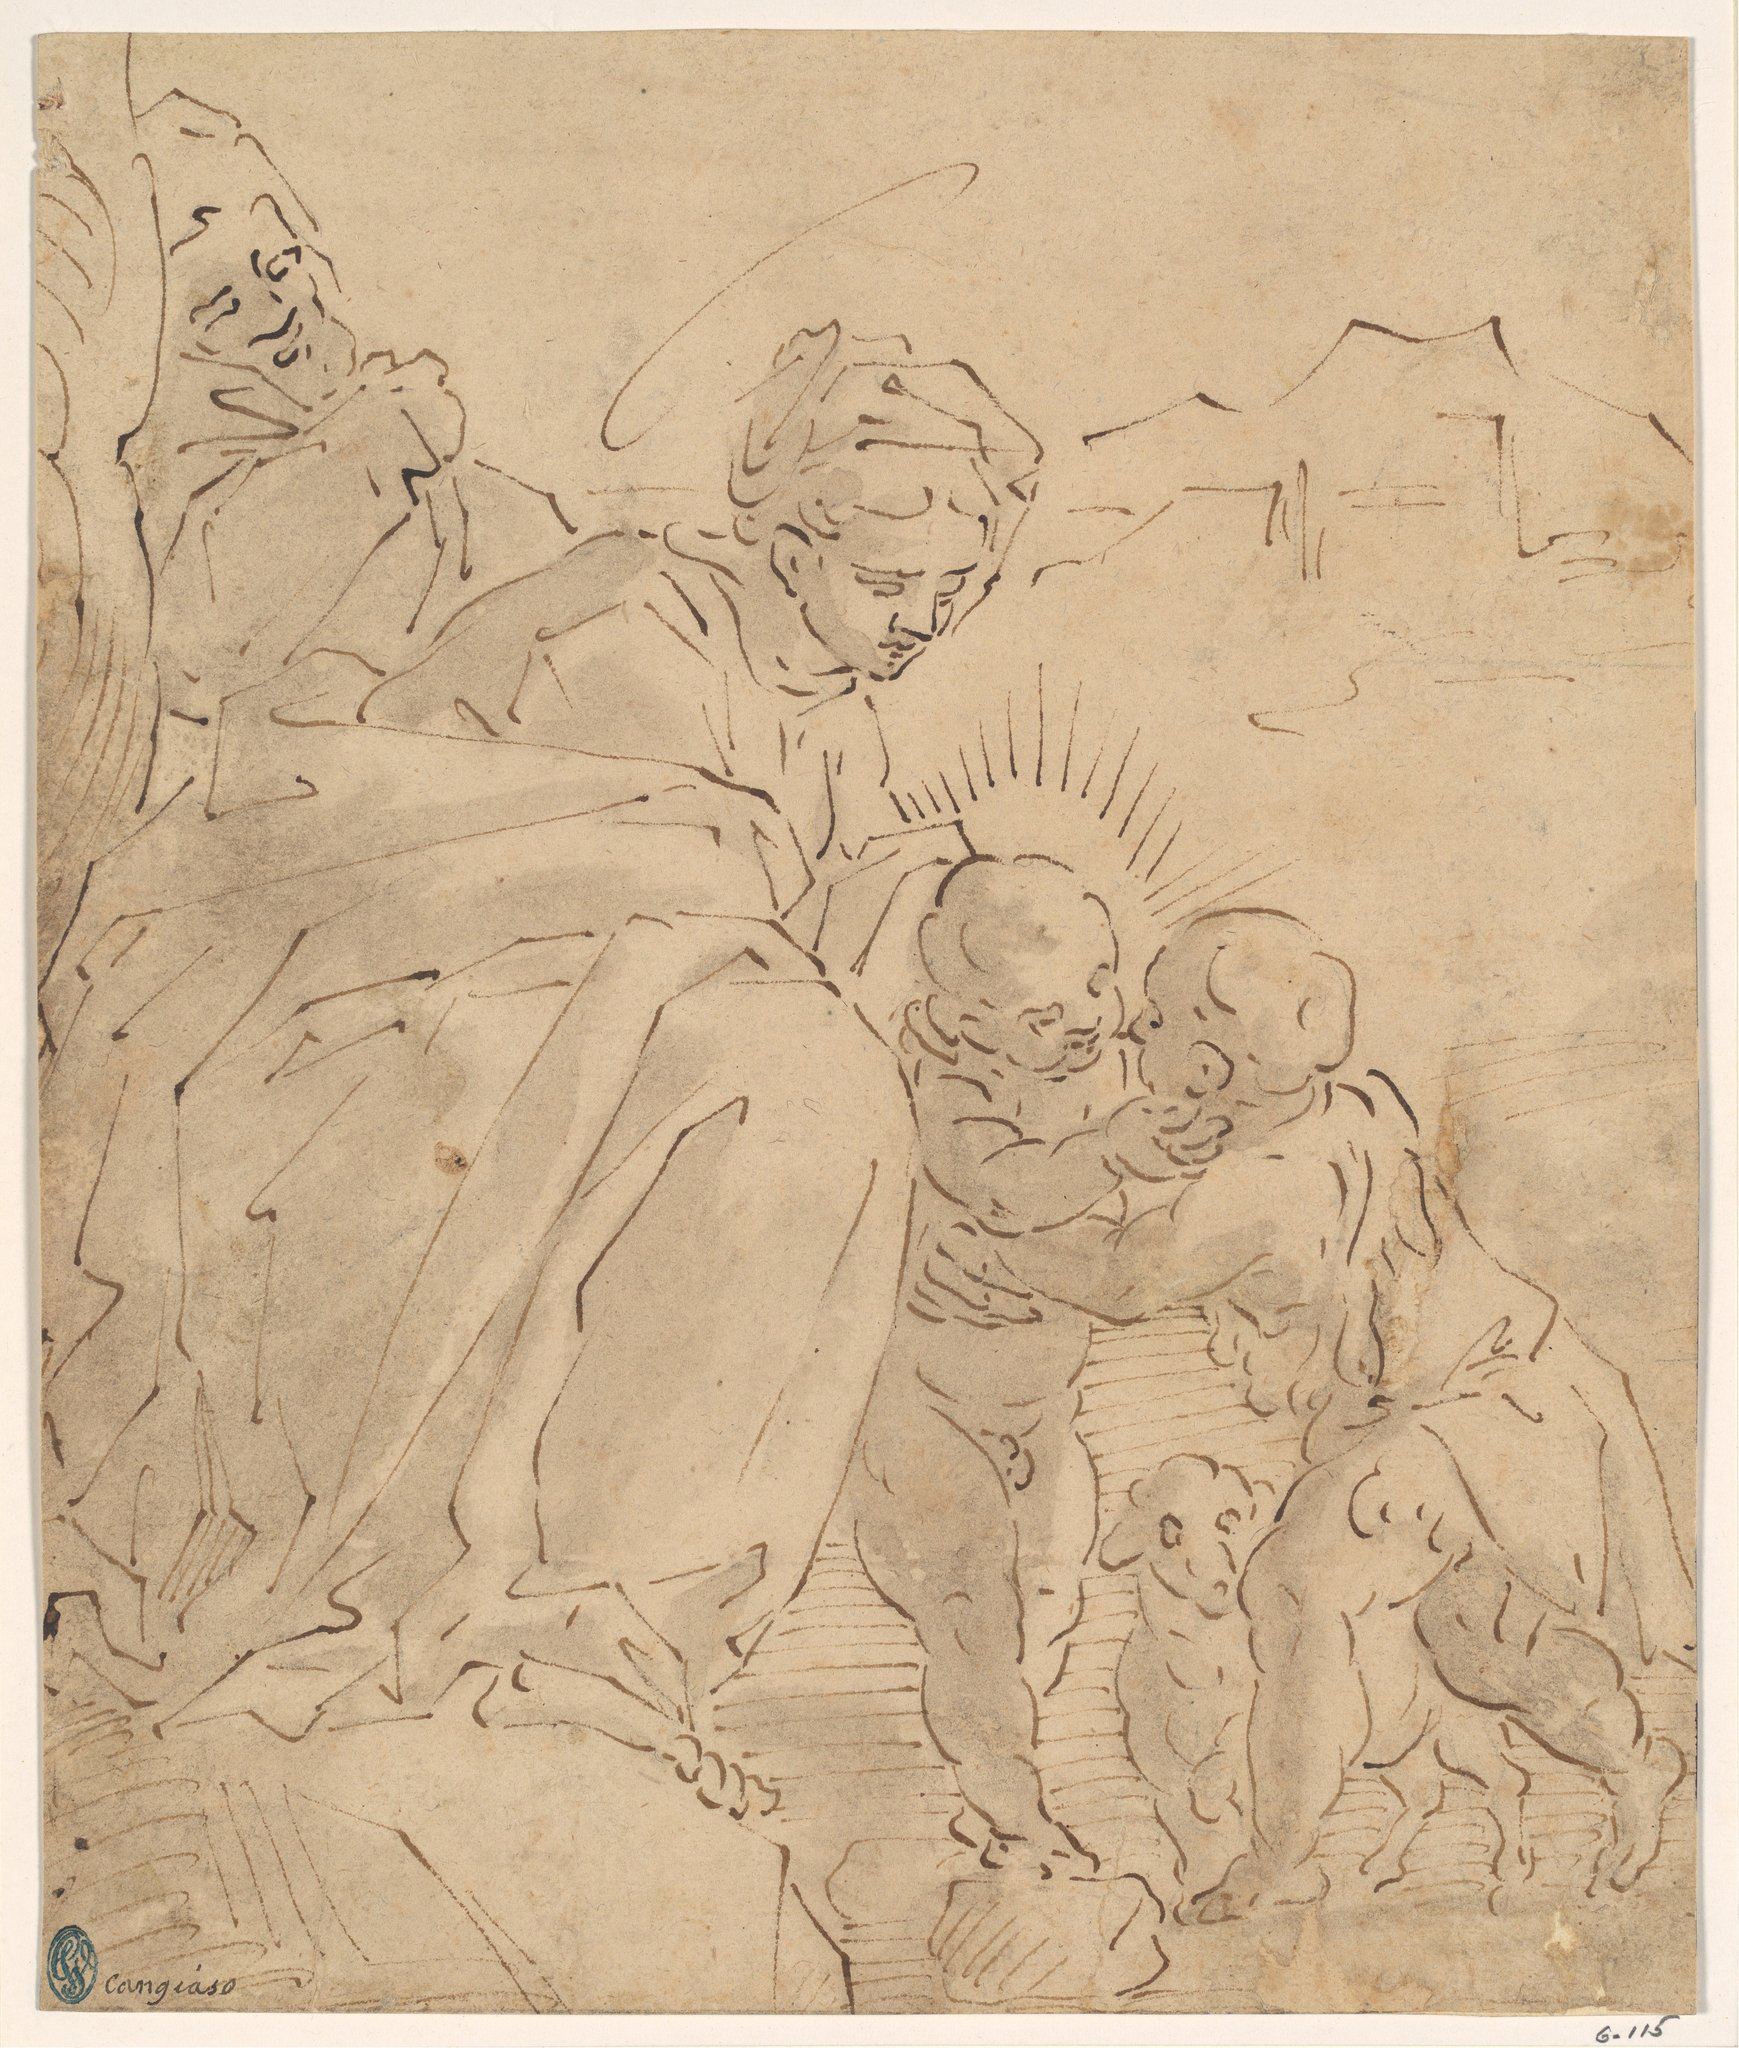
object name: drawing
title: The Holy Family with the Young Saint John the Baptist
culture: italian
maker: school of cambiaso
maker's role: artist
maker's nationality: italian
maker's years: 1527-1585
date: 1567-1600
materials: ink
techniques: pen, wash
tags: holy family,saint john the baptist